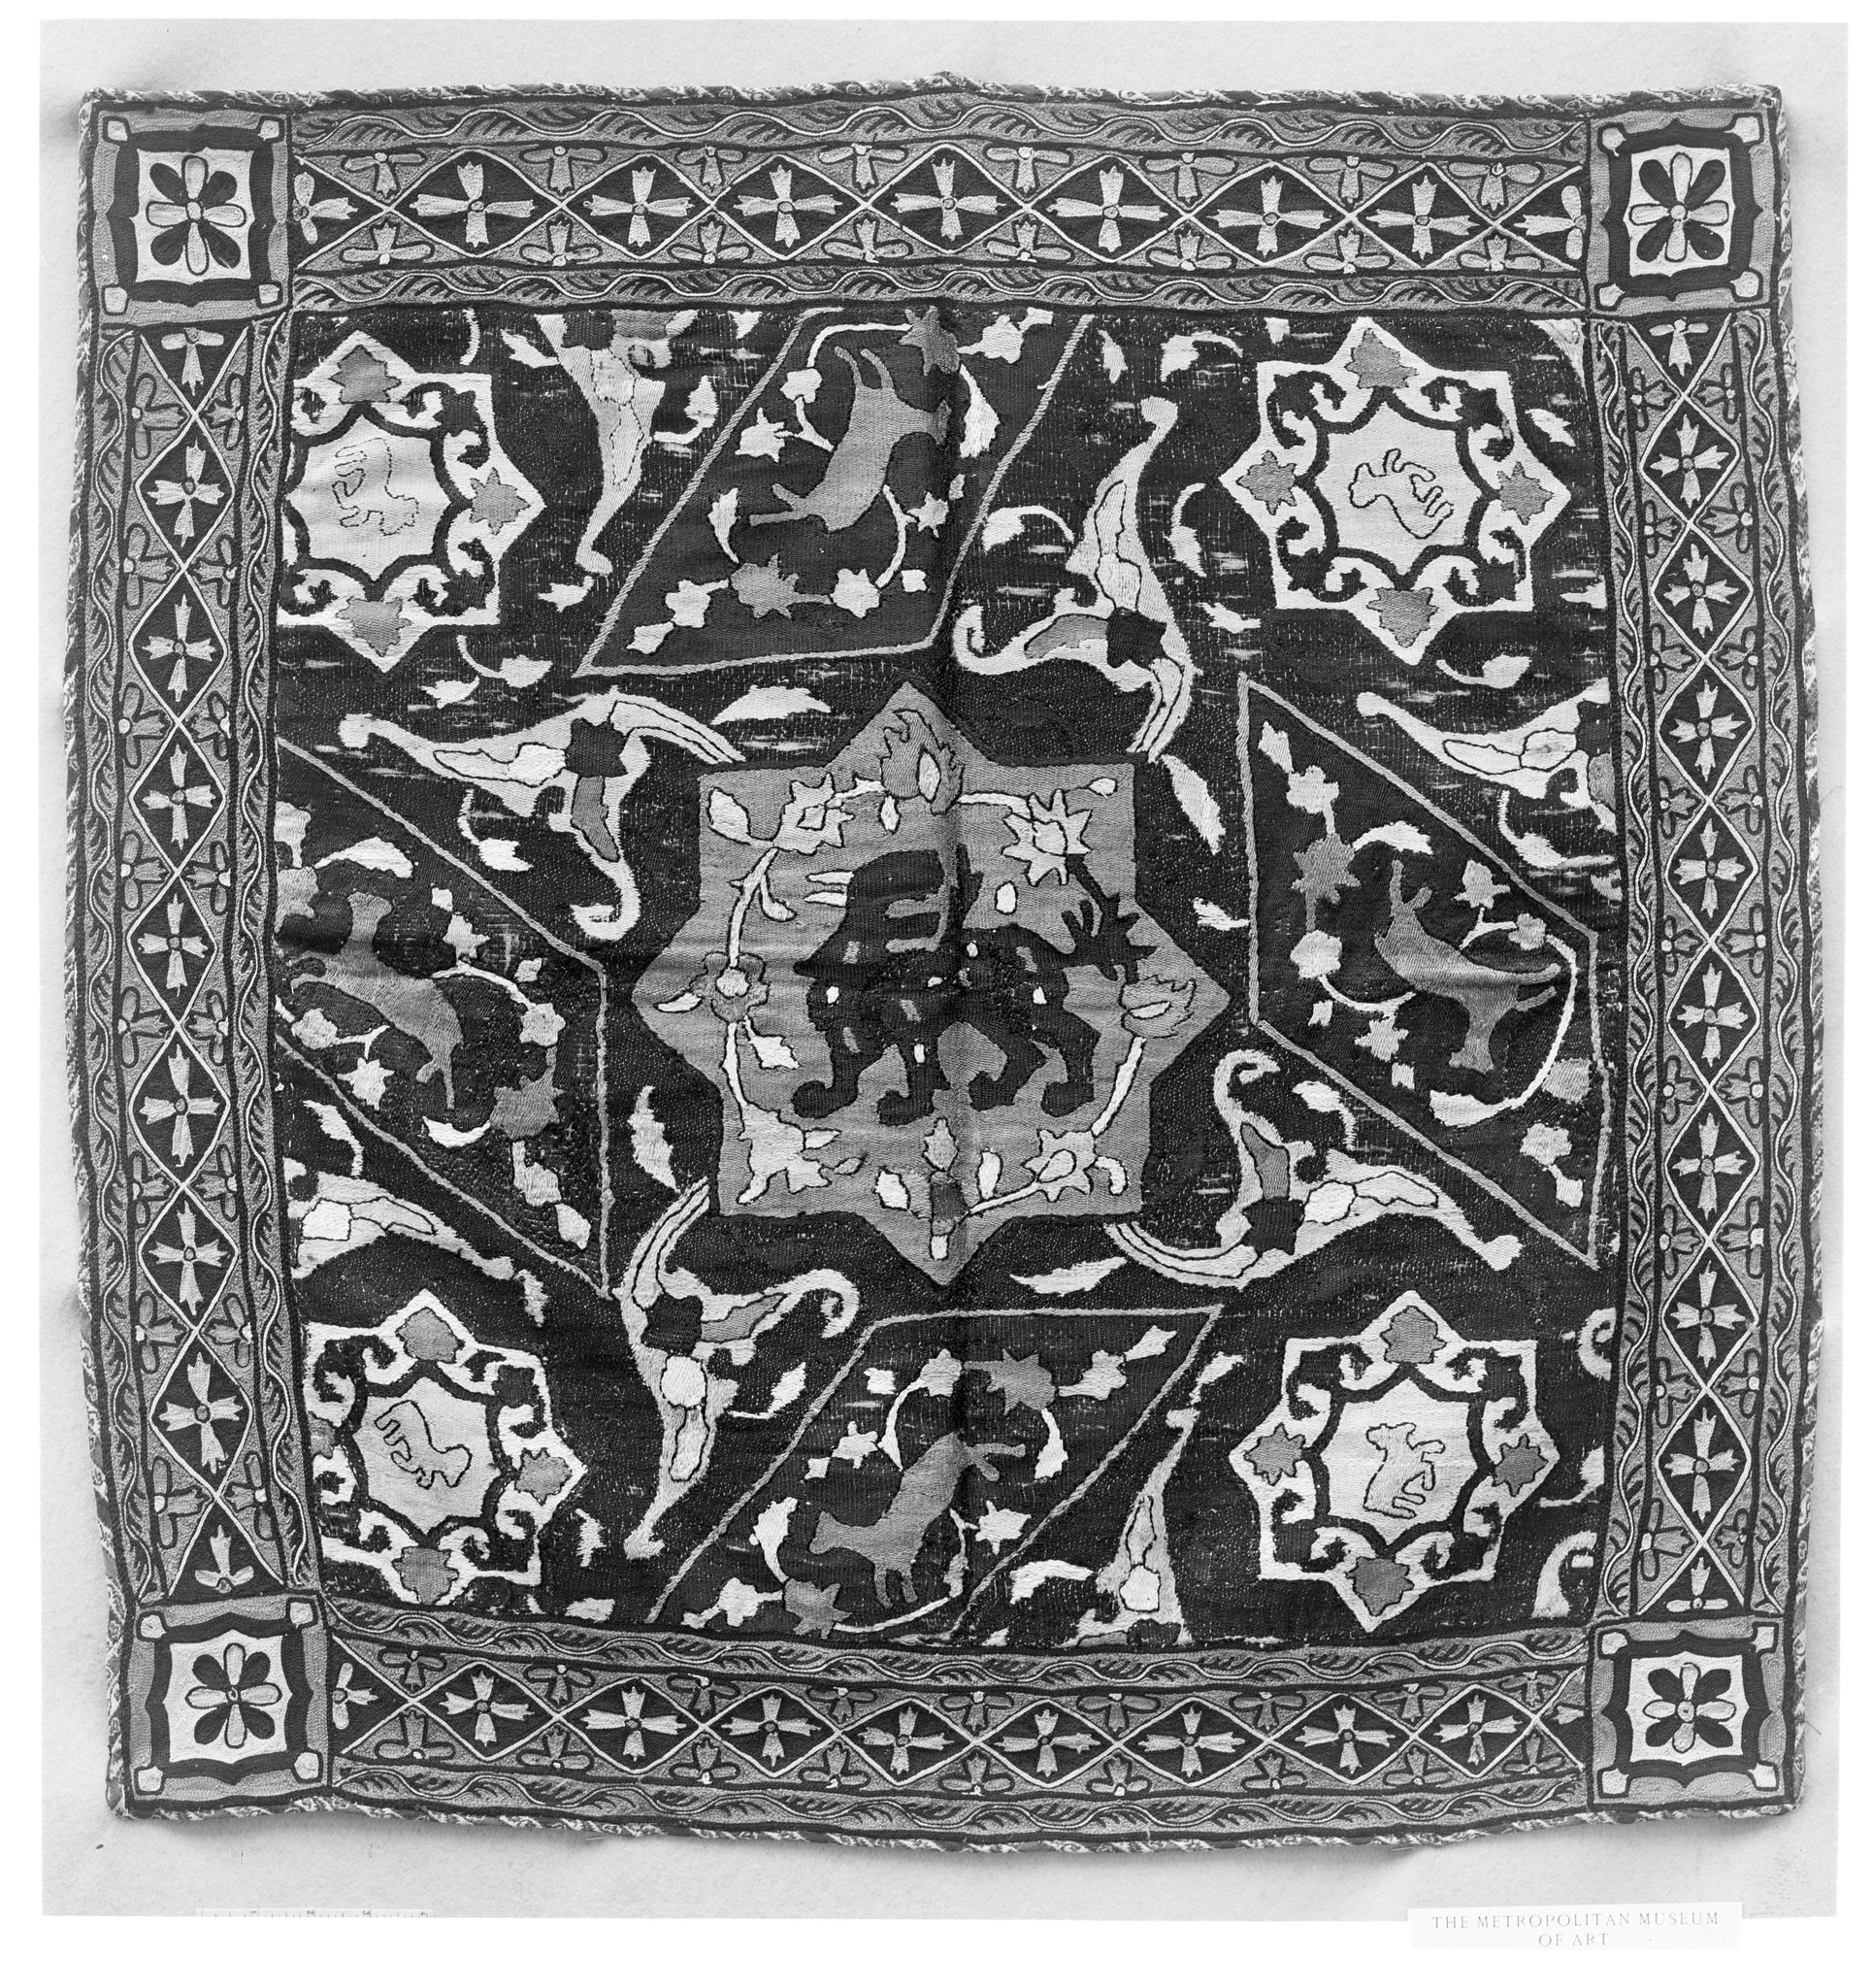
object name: cover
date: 1701-1800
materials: cotton, silk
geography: iran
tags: animals